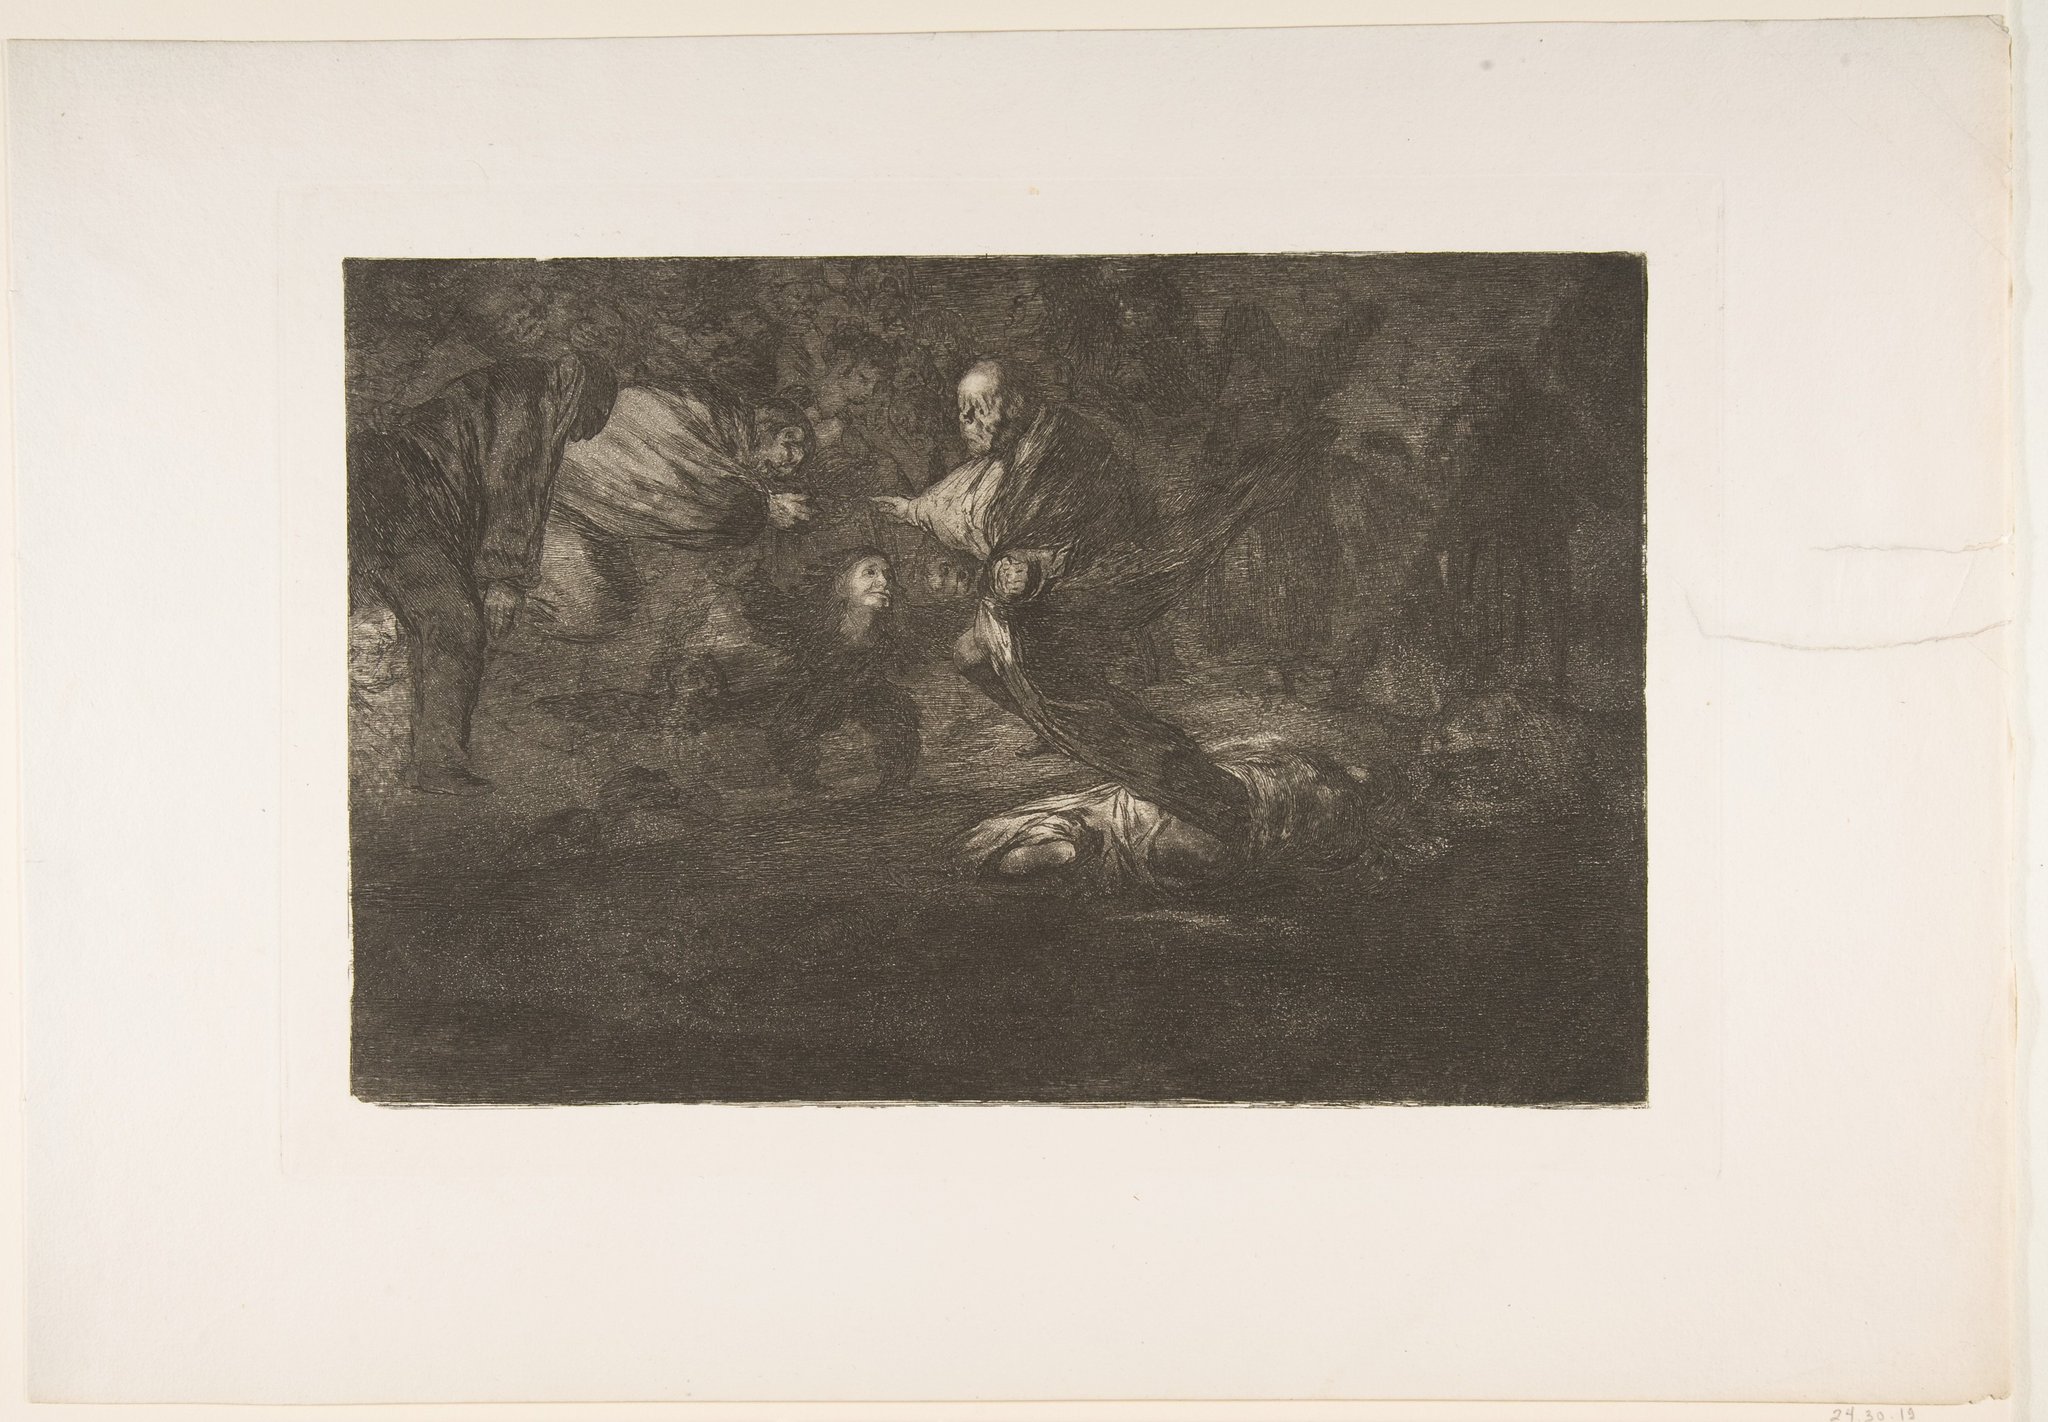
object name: print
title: Funereal Folly, from "The Disparates" (Follies / Irrationalities)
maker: goya (francisco de goya y lucientes)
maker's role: artist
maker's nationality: spanish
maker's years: 1746-1828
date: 1815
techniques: aquatint, burnishing, etching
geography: spain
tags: birds,men,women